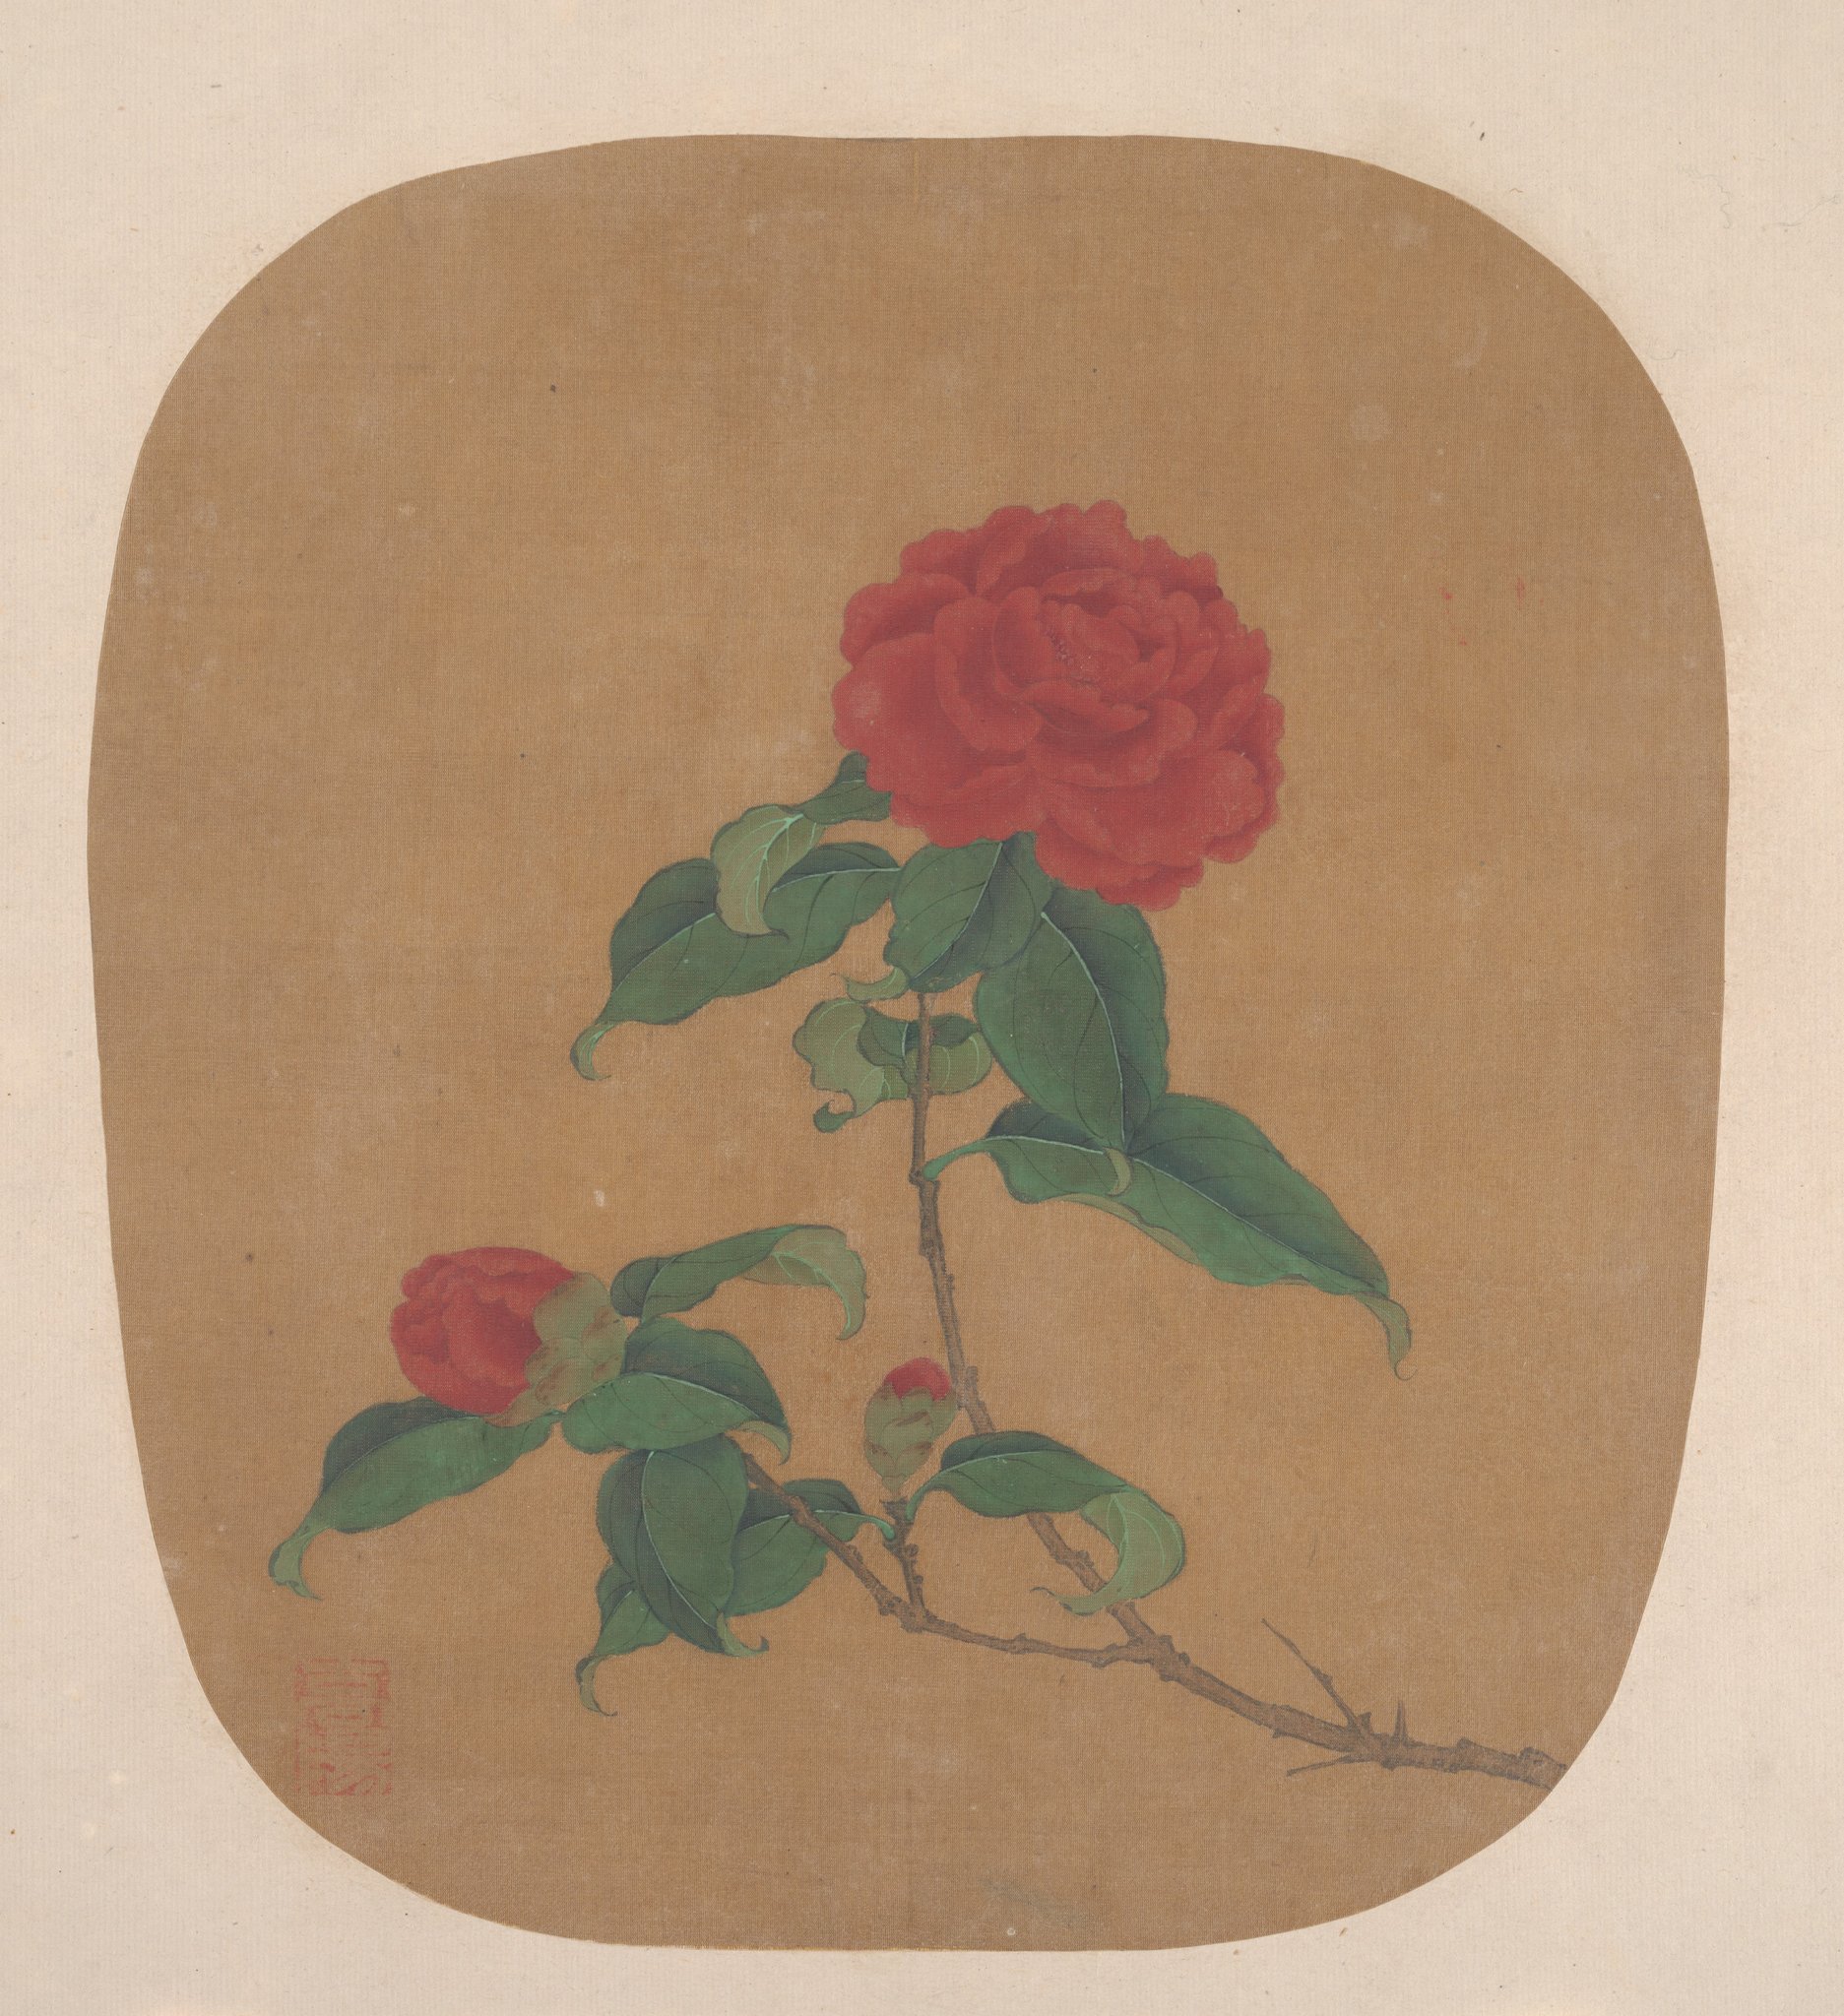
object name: fan mounted a an album leaf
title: Camellia Flowers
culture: chinese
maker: unidentified artist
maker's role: artist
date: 1368-1911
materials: ink, silk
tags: flowers